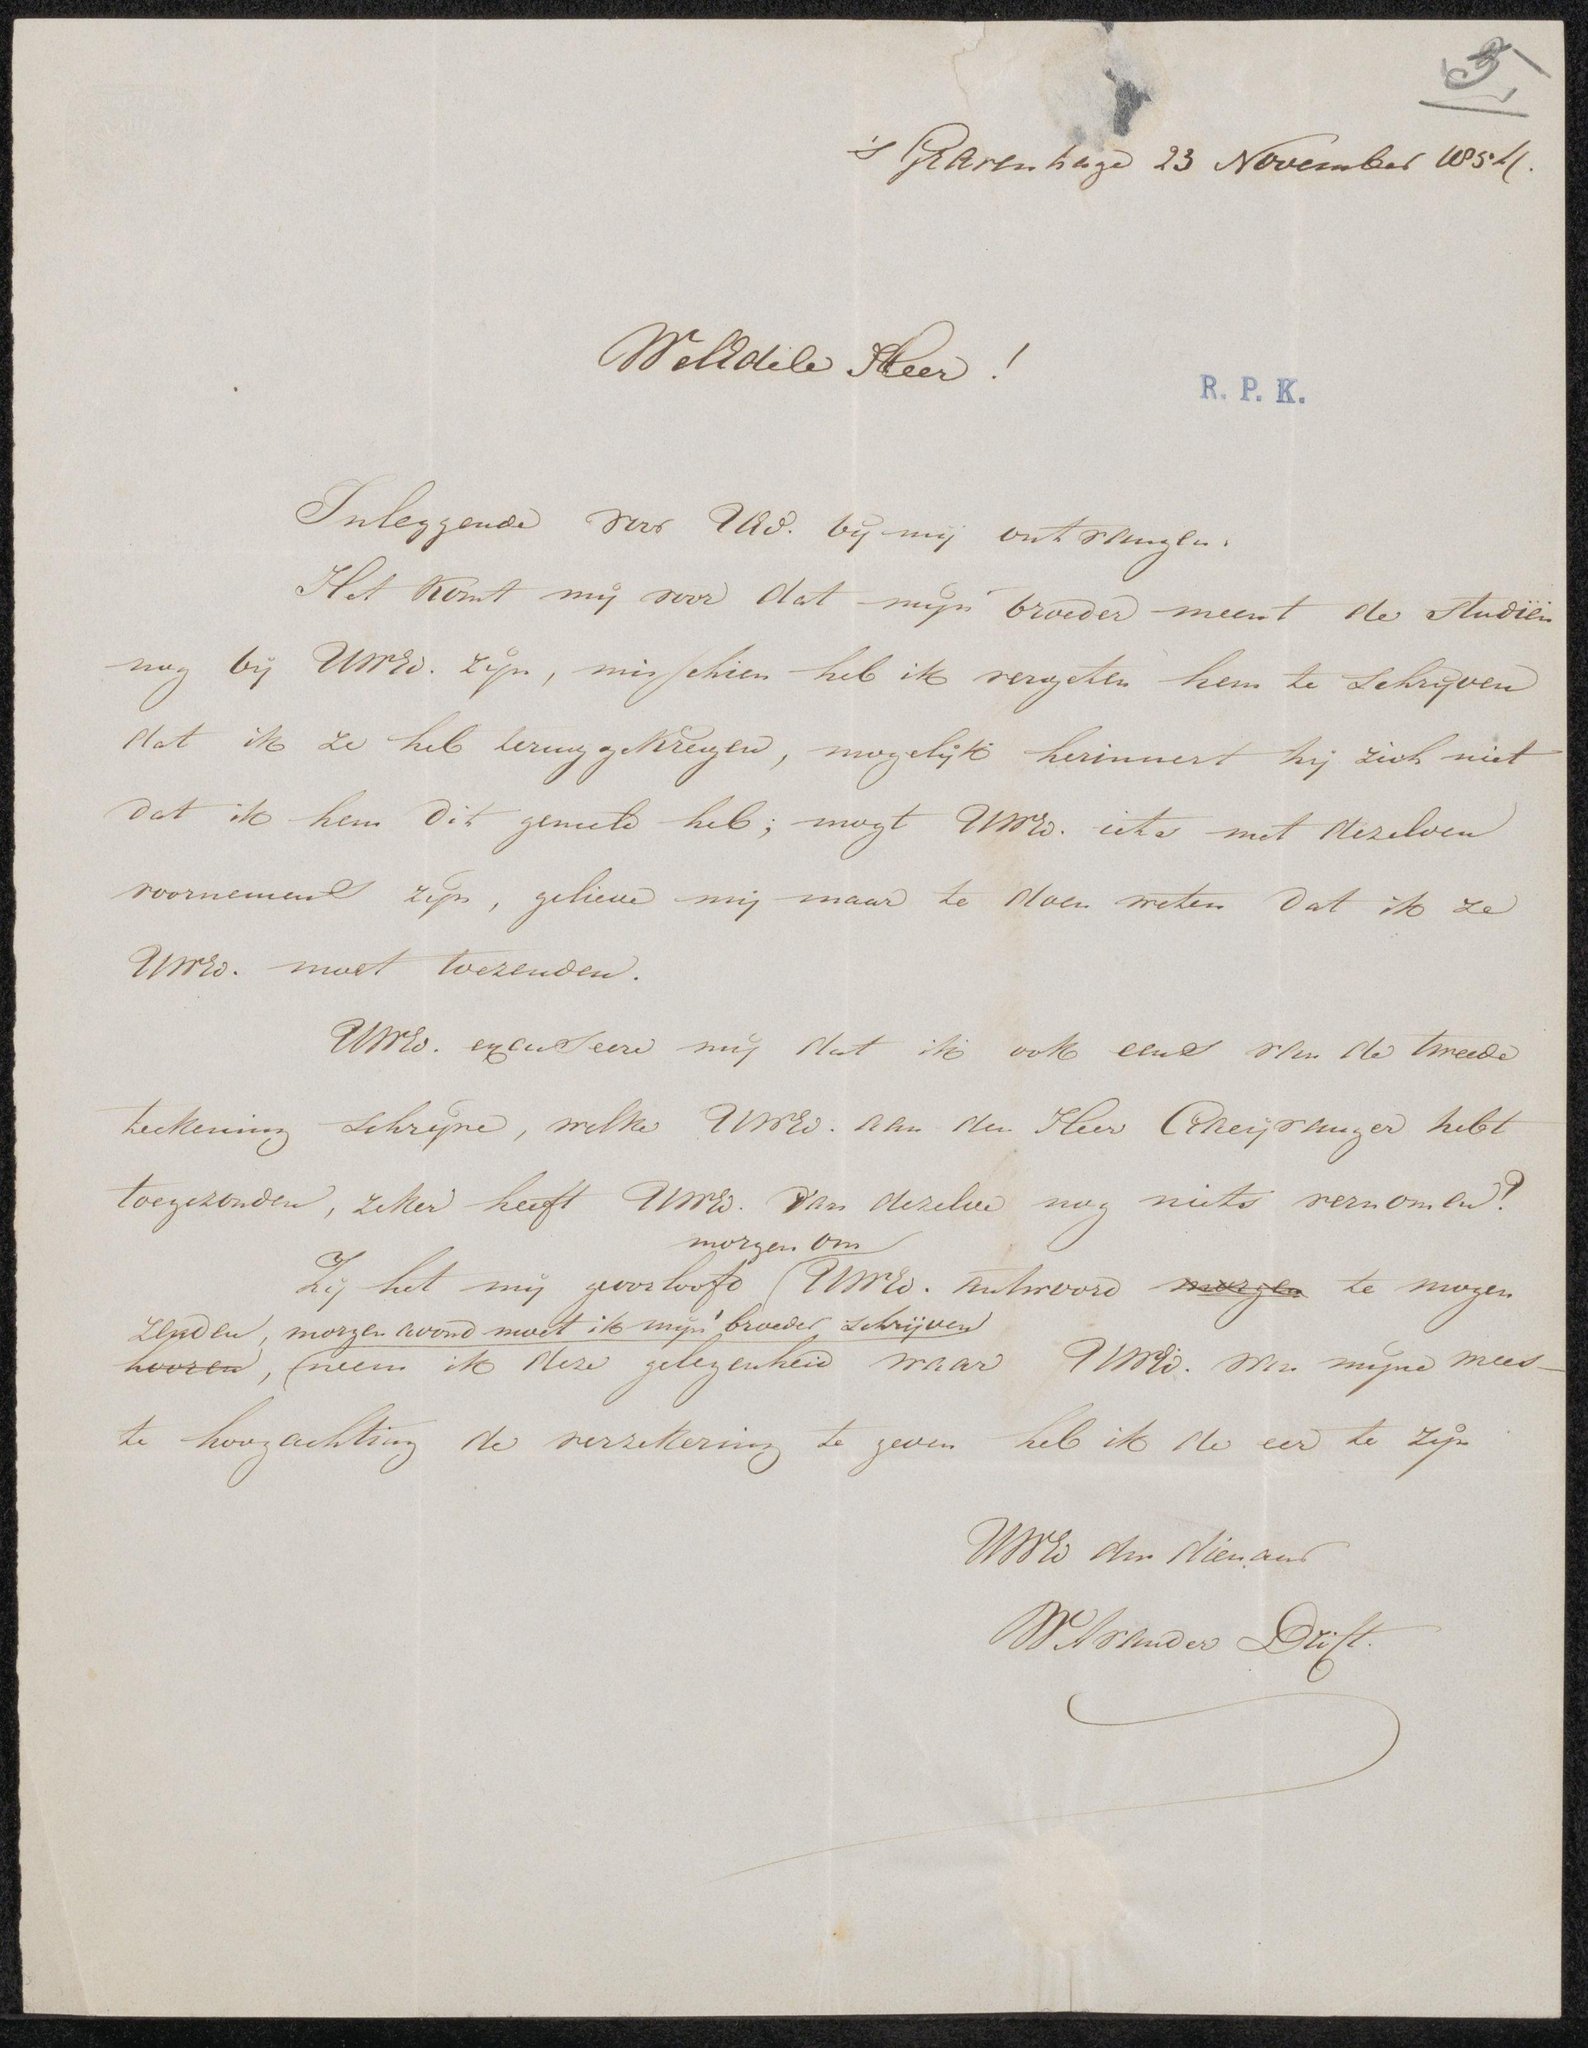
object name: letter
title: Brief aan Lambertus Hardenberg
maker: w.a. van der drift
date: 1854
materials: ink, paper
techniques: pen, writing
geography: the hague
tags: johannes adrianus van der drift, the hague, painter, print maker, draughtsman, lambertus hardenberg (1822-1900), drawing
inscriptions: collector's mark: Lugt 2233